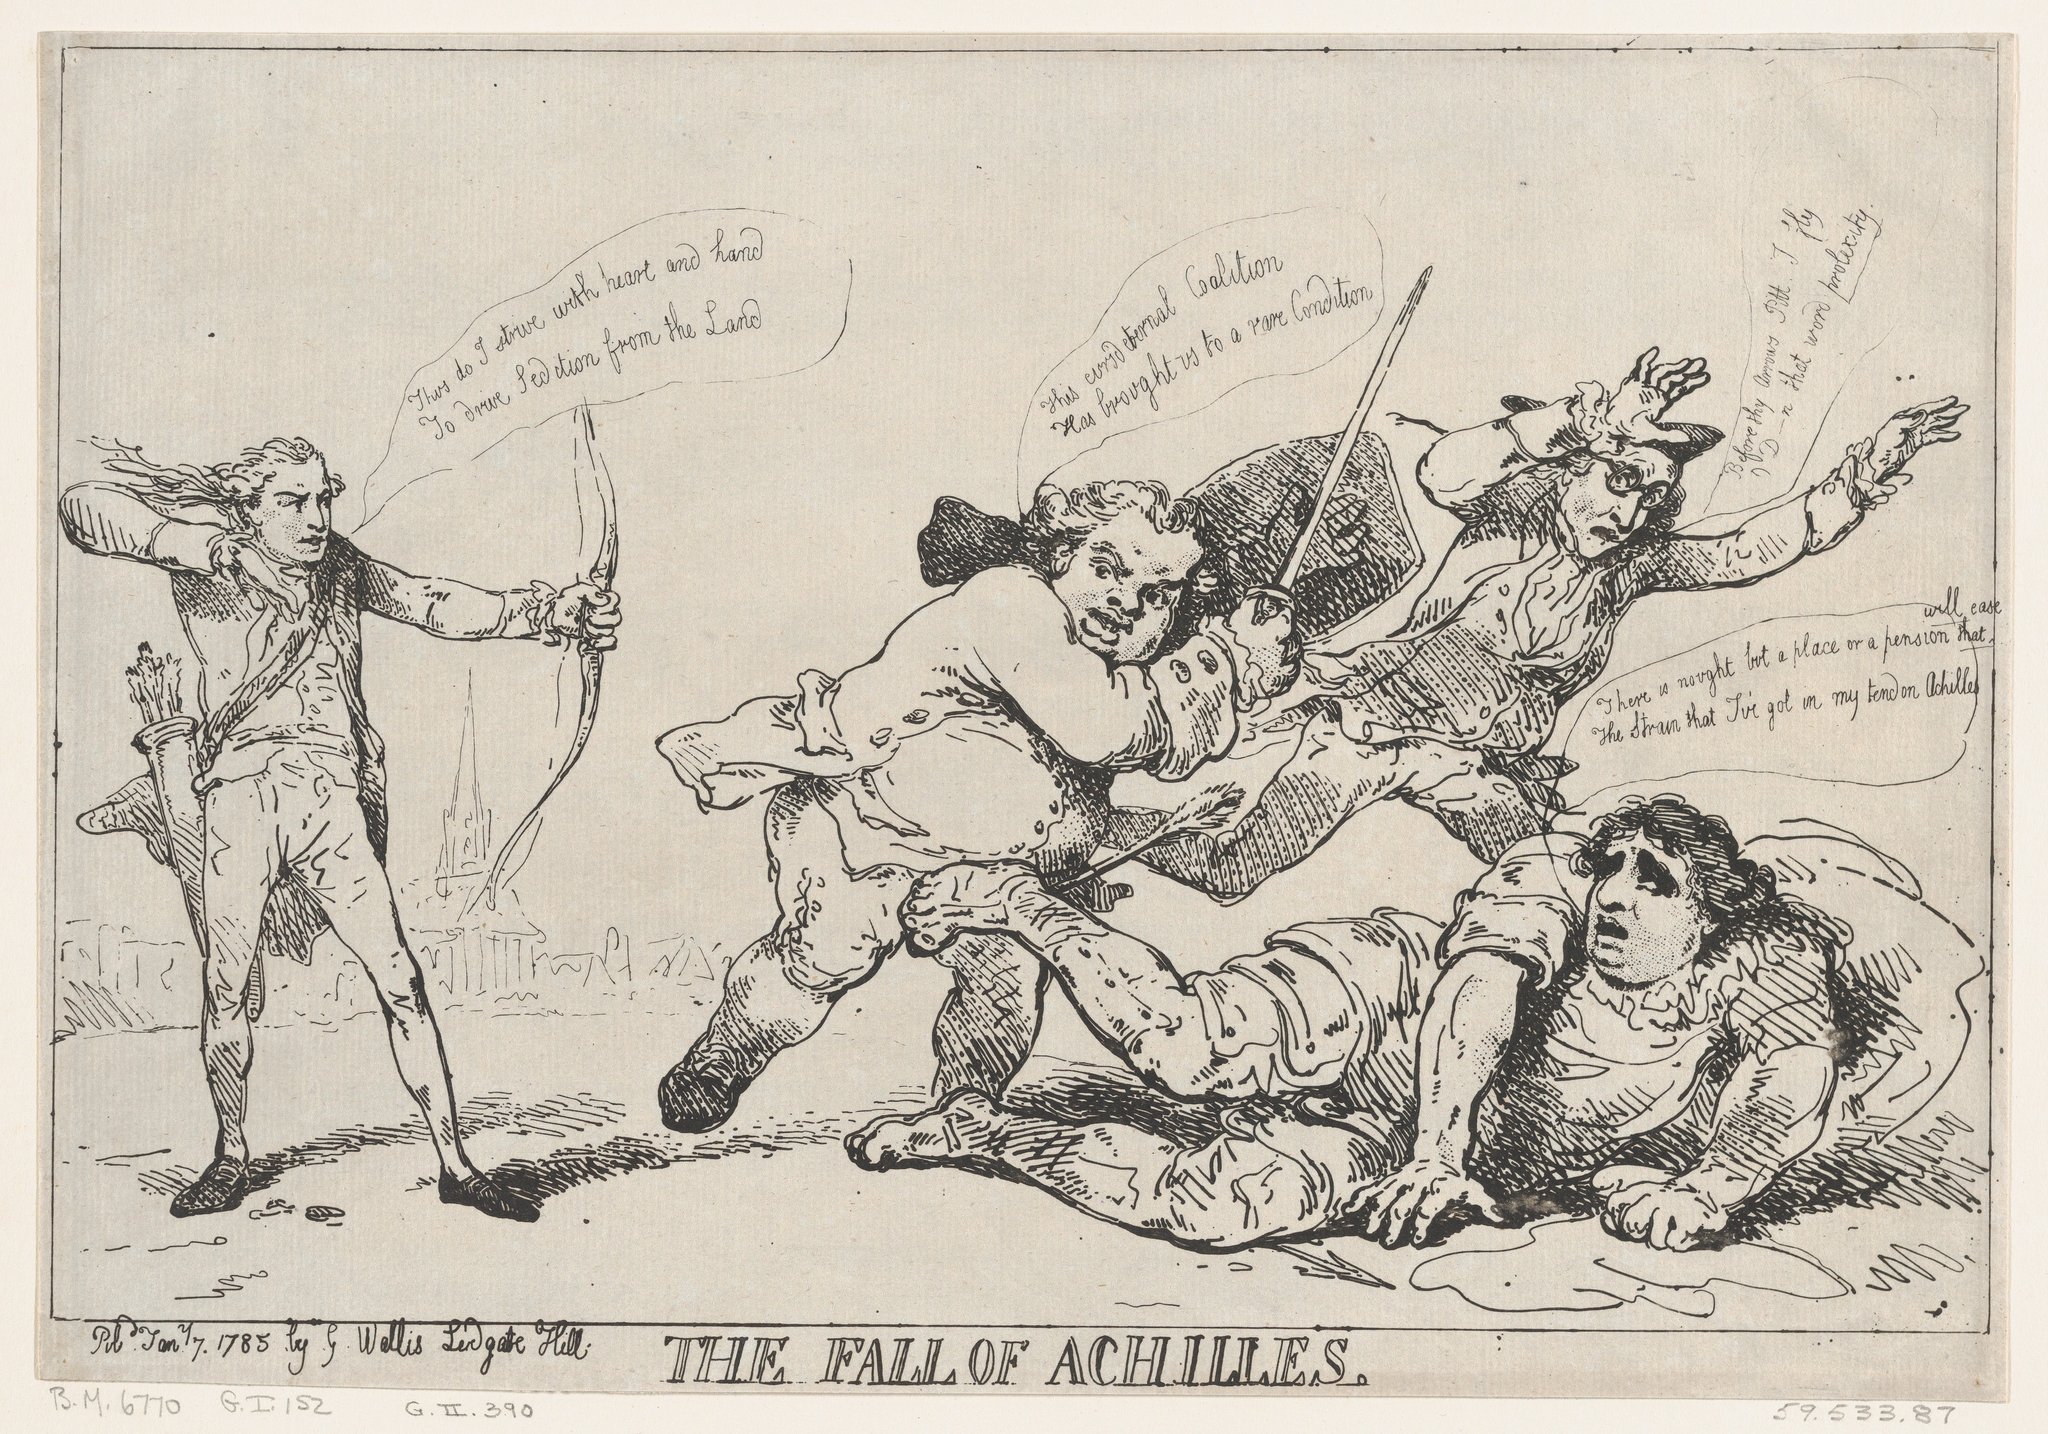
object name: print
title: The Fall of Achilles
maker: thomas rowlandson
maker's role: artist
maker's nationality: british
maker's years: 1757-1827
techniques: etching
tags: satire,men,politics